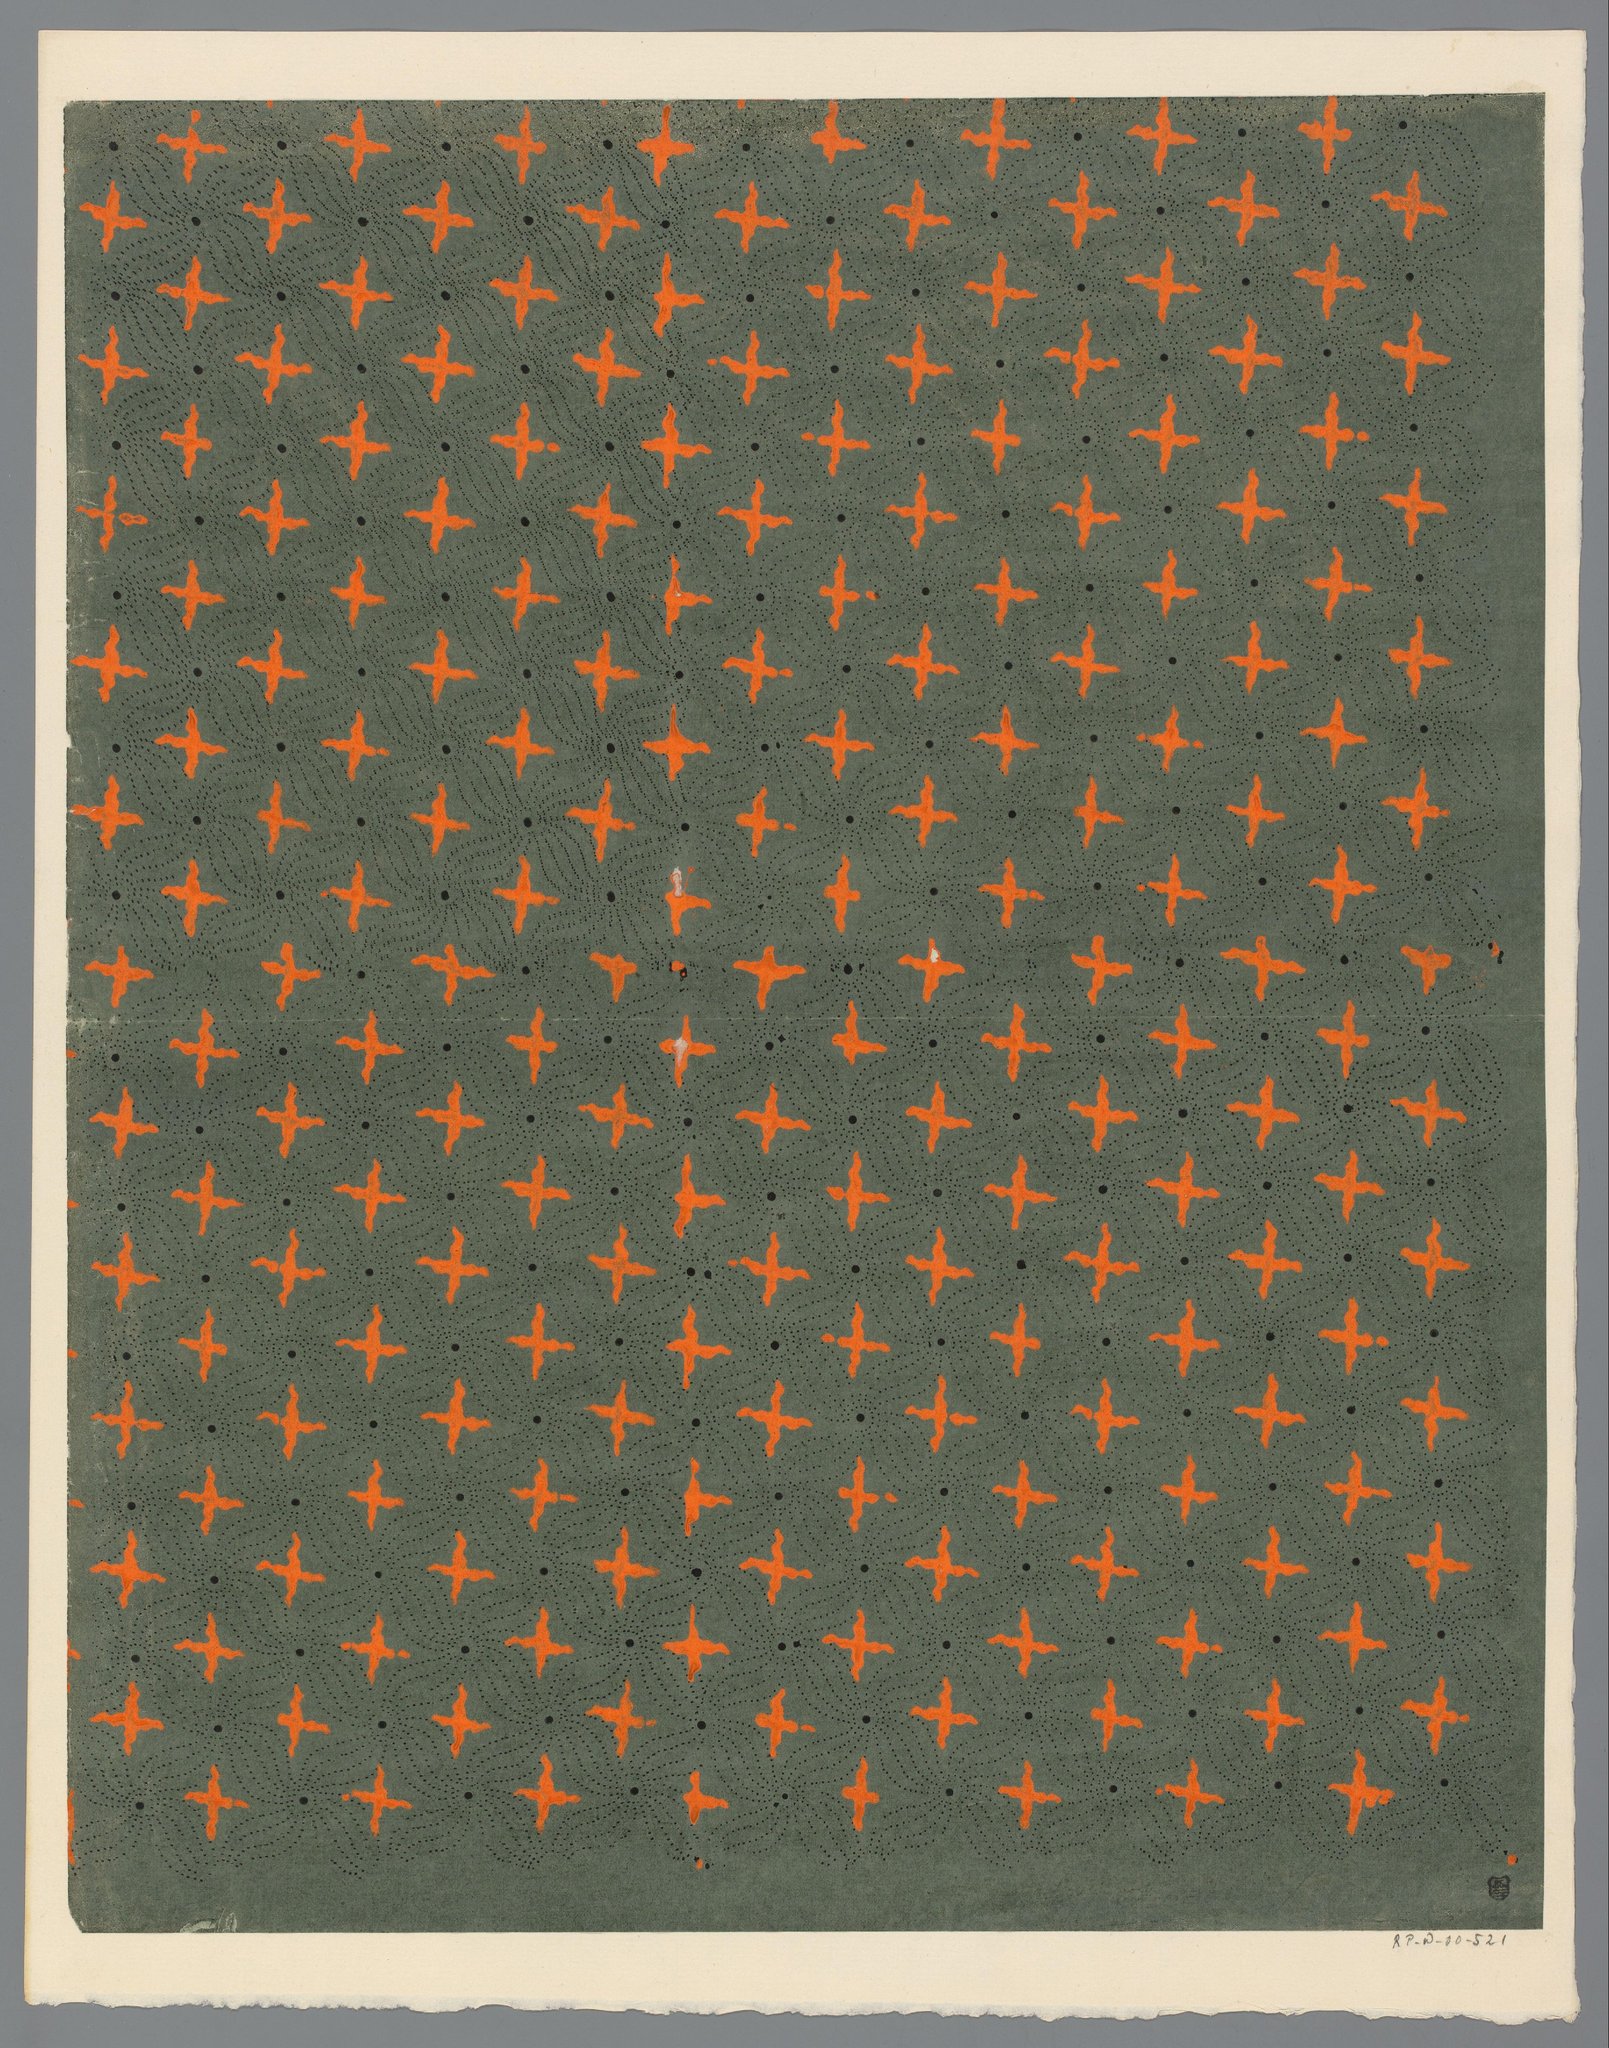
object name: printed paper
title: Blad met strooipatroon van kruismotief tussen een kruis van golvende stippellijnen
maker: Anonymous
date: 1800-1900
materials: paint, paper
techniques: printing block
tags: fantasy ornament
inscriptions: collector's mark: Lugt 2760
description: Blad met strooipatroon van kruismotief tussen een kruis van golvende stippellijnen.